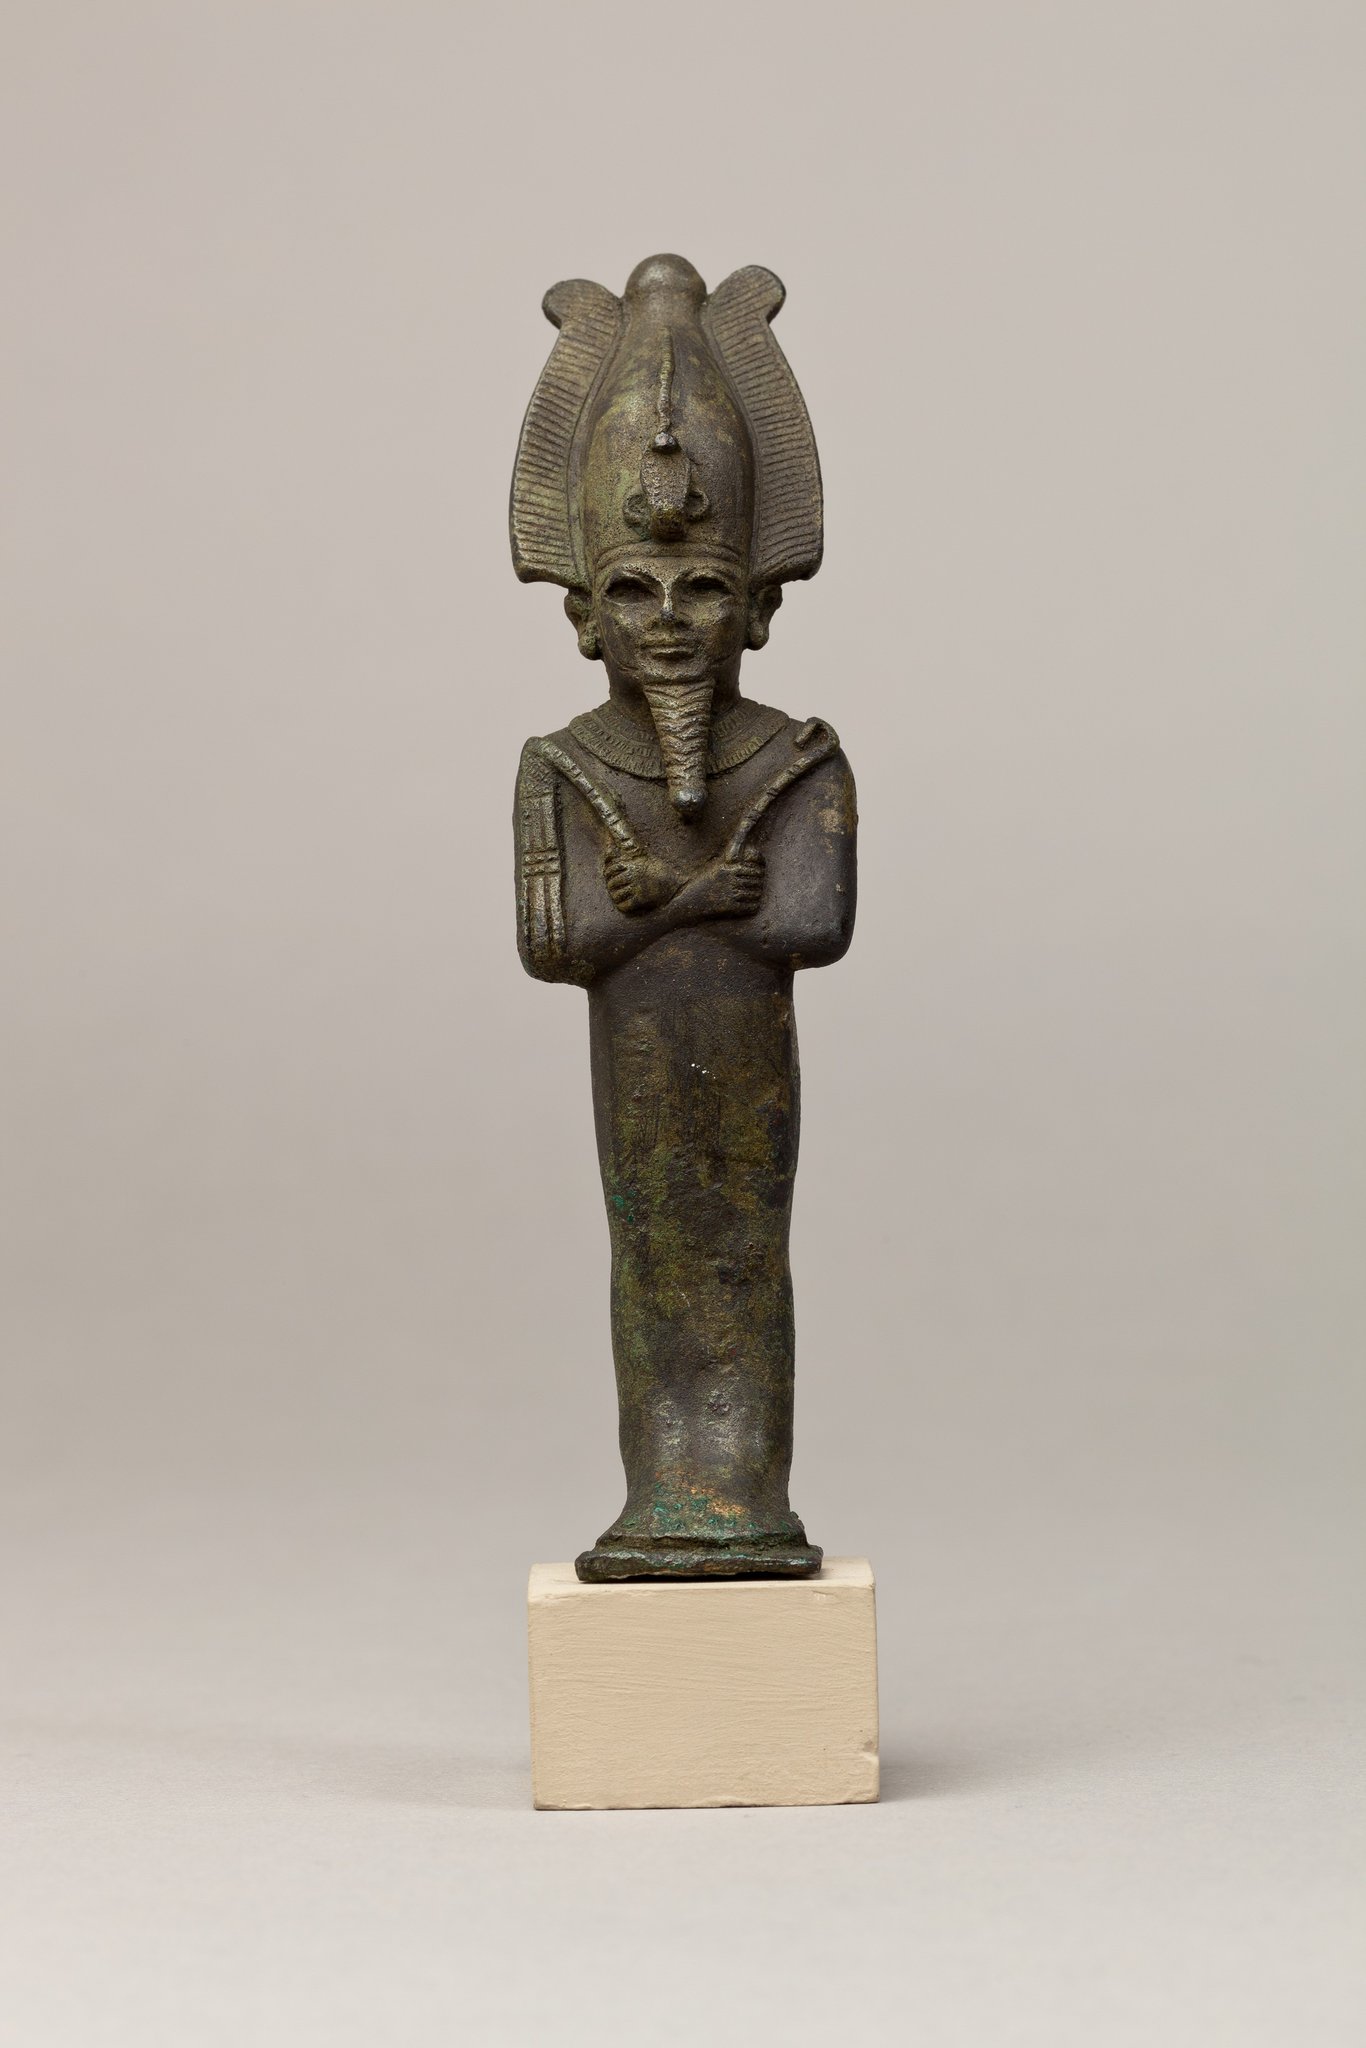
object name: statuette, osiris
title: Osiris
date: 664-630 BCE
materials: metal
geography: egypt